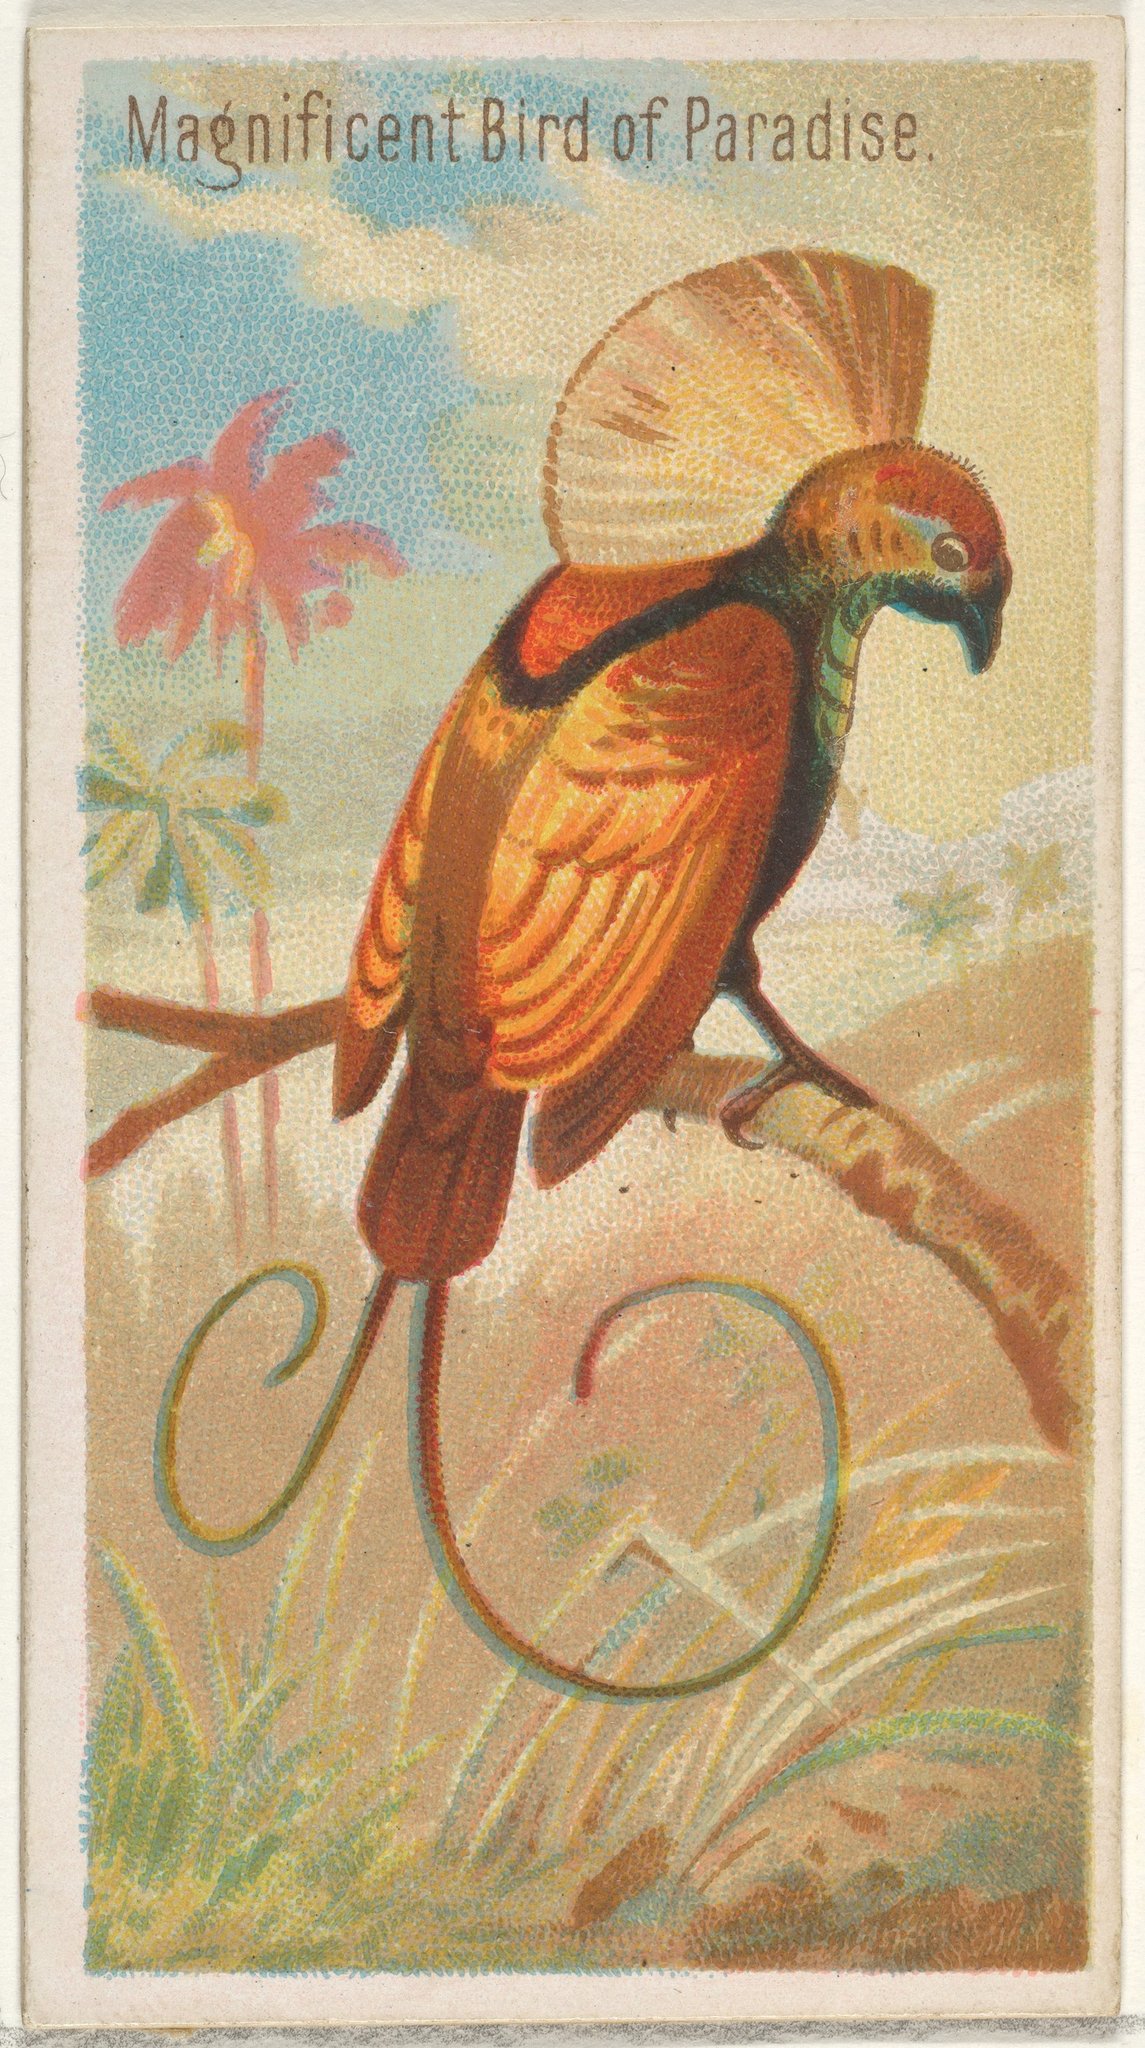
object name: print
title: Magnificent Bird of Paradise, from the Birds of the Tropics series (N5) for Allen & Ginter Cigarettes Brands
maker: allen & ginter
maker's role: publisher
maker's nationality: american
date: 1889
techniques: color lithograph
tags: birds